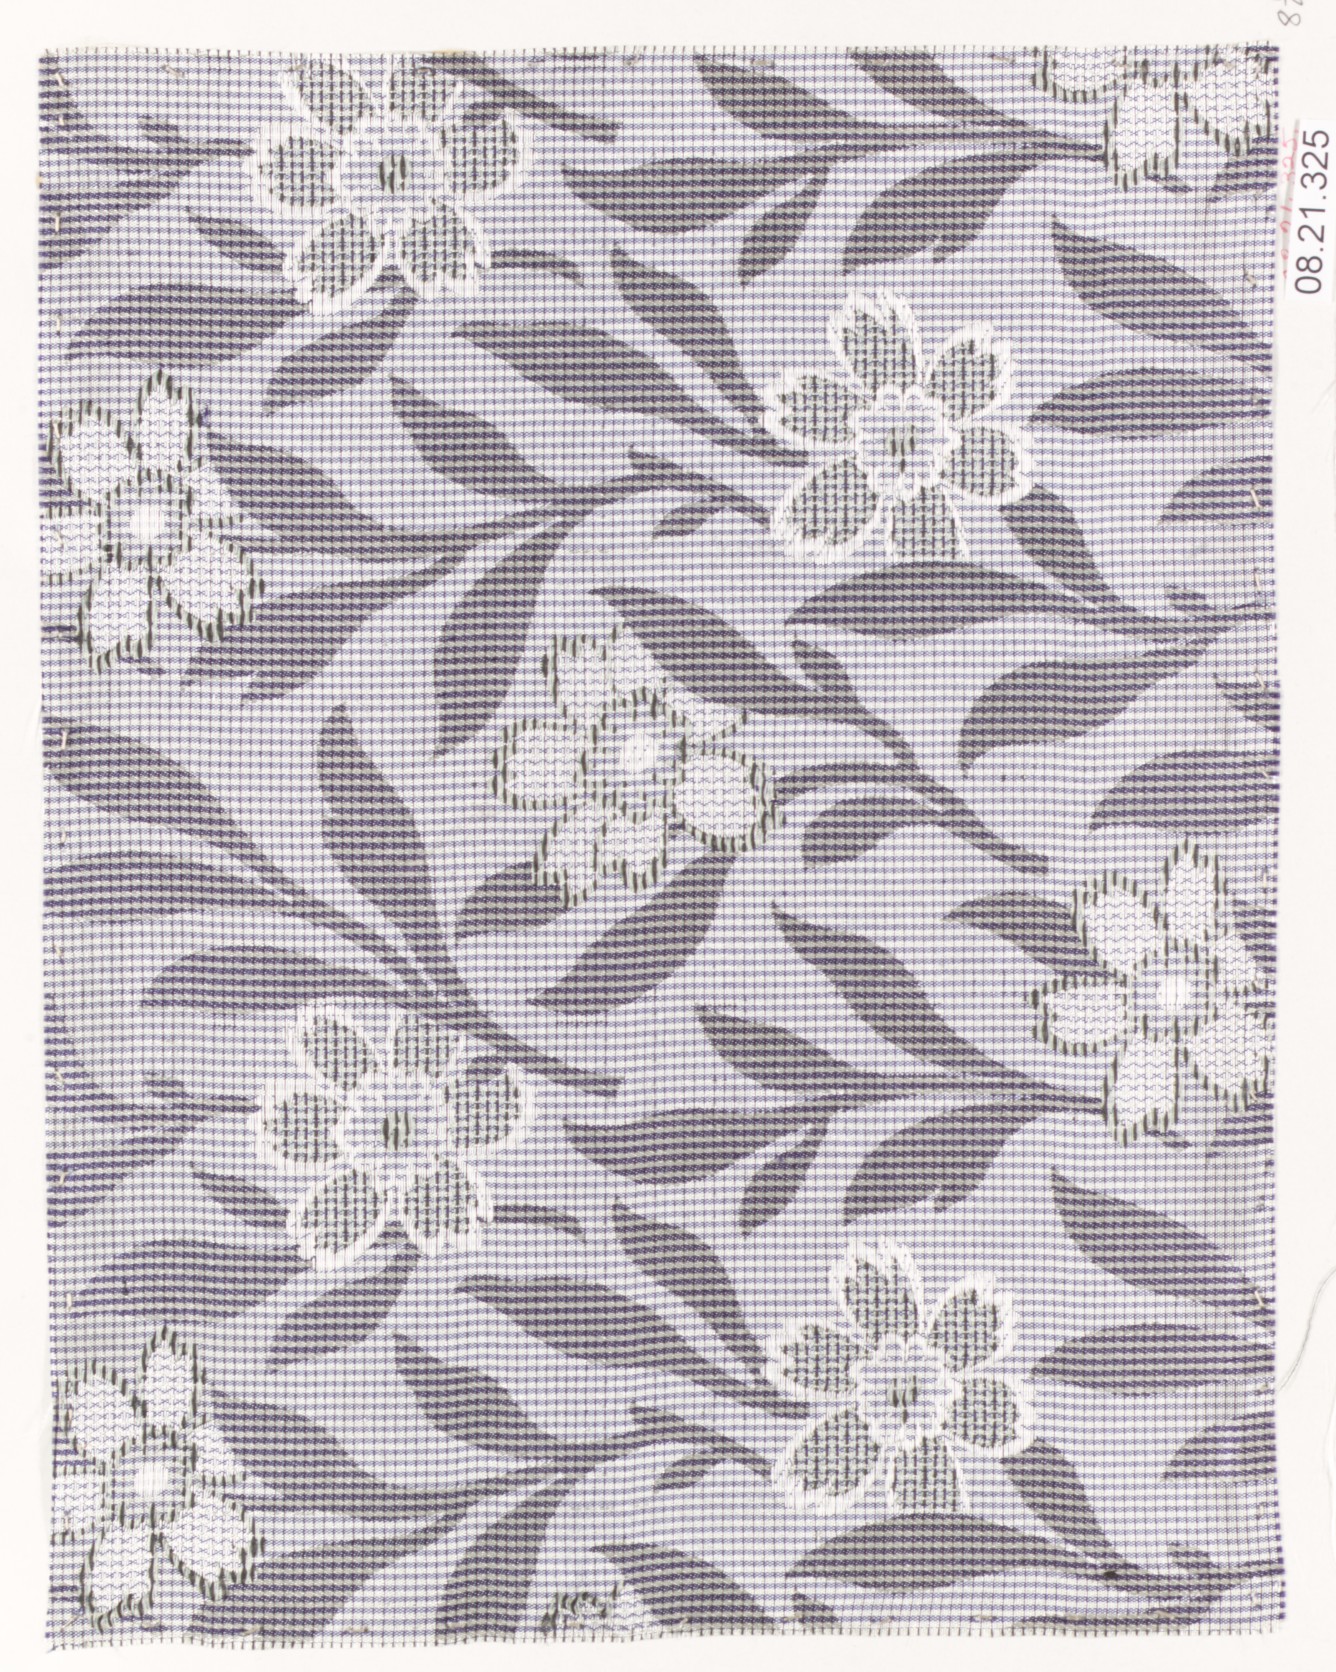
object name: textile sample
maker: Anonymous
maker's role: designer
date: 1900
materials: silk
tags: flowers